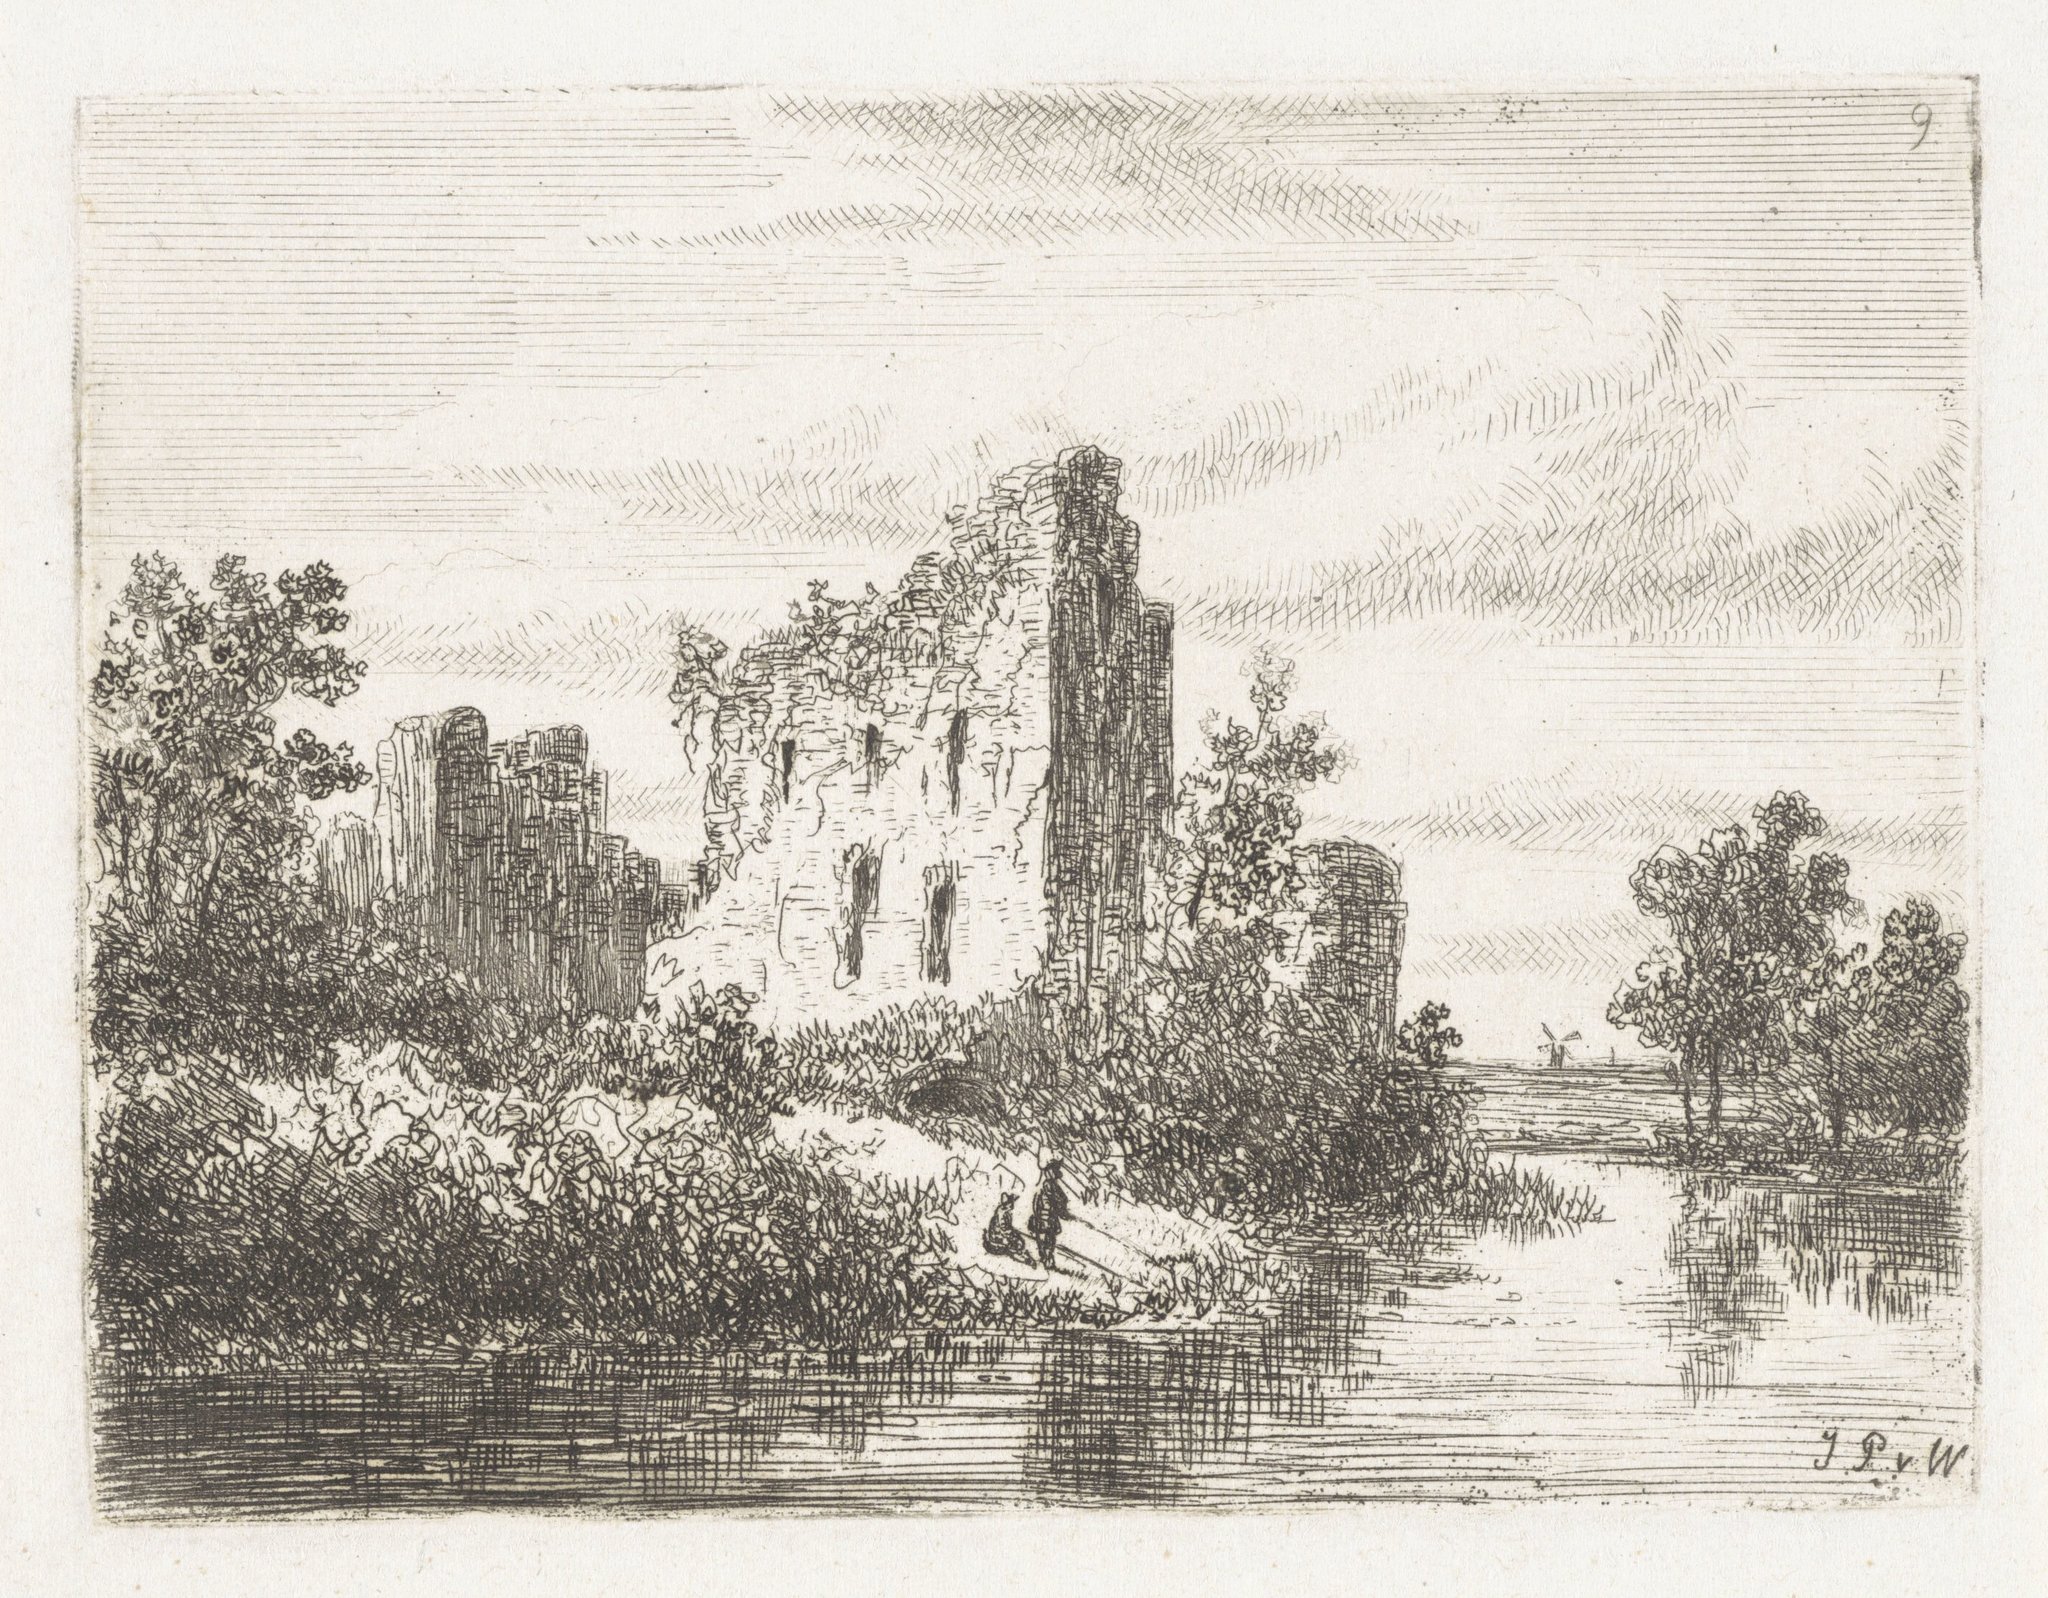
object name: print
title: Ruïne aan een rivier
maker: johannes pieter van wisselingh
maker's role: draughtsman, painter, print maker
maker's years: 1812-1899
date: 1830-1878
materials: paper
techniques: etching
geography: netherlands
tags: river, landscape with ruins, angling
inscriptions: collector's mark: Lugt 2228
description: Links een ruïne aan een rivier. Op de oever bij de ruïne twee vissers. In de verte een molen. Rechtsboven het cijfer 9.